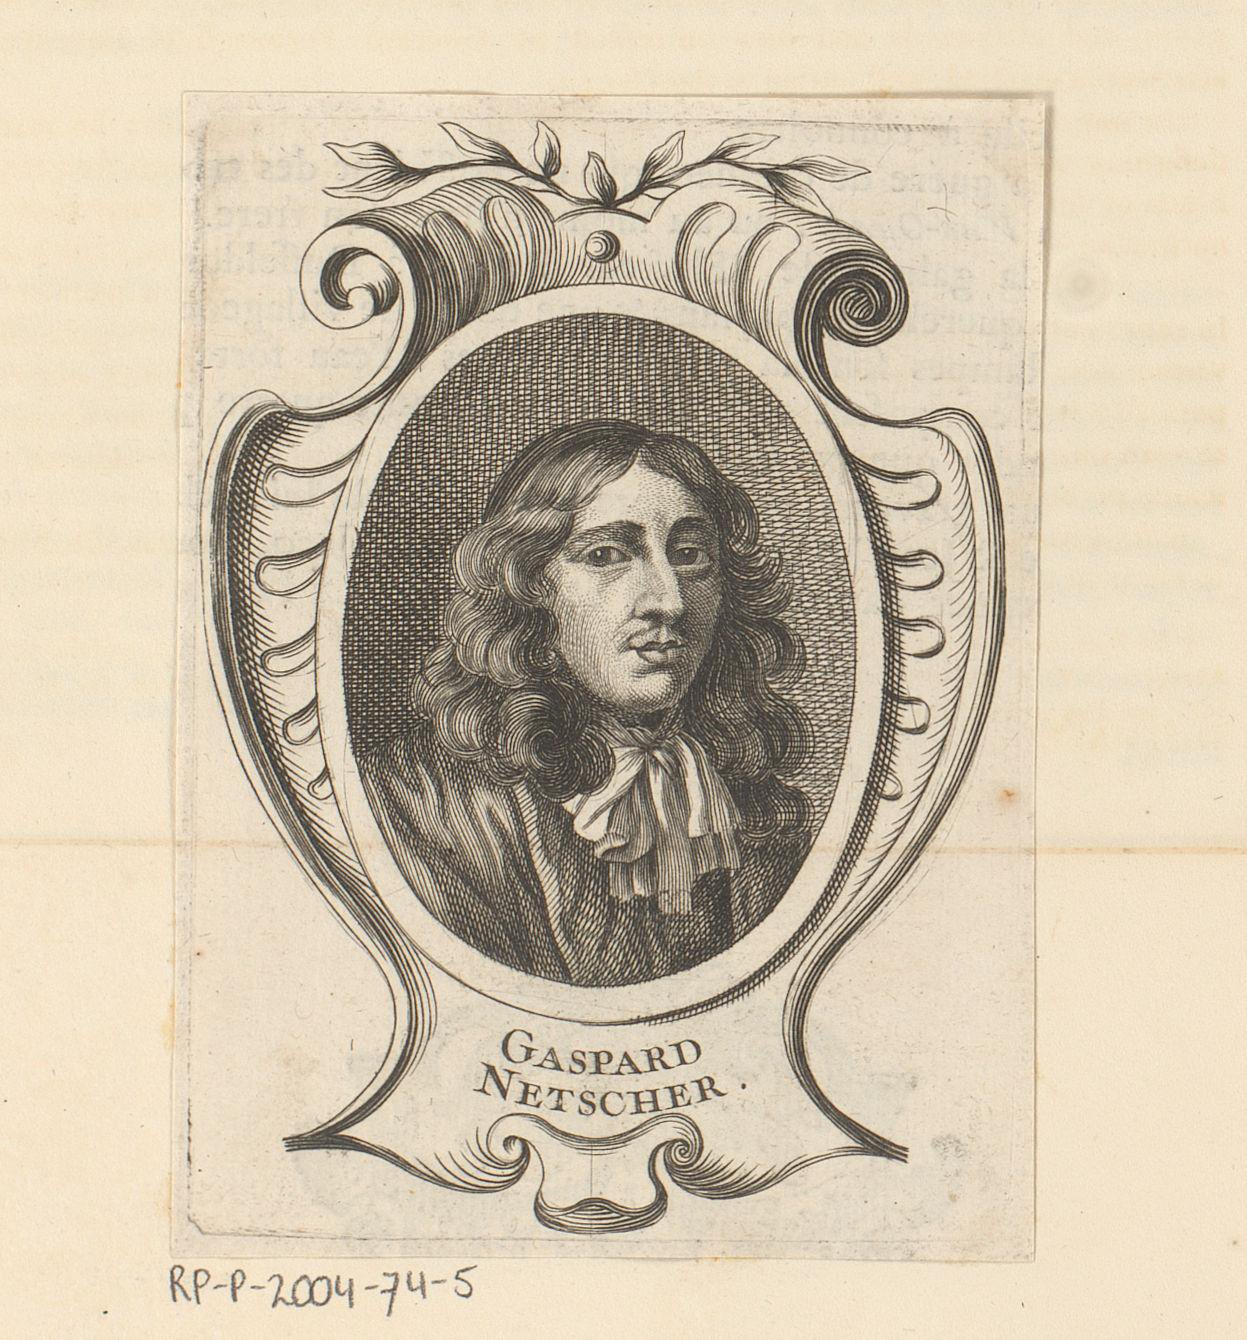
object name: print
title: Portret van Caspar Netscher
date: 1745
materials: paper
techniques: engraving, letterpress printing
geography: paris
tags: the hague, painter, print maker, draughtsman, caspar netscher, historical persons, portrait, self-portrait of painter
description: Prent uit: Dézallier d'Argenville, Antoine Joseph. Abrégé de la vie des plus fameux peintres. 4 dln. Parijs: De Bure l'aîné, 1745, dl. 2, p. 38. De samensteller heeft deze prent in het album geplakt als illustratie bij: Pilkington, Matthew en Johann Heinrich Füssli. A dictionary of painters, from the revival of the art to the present period. 4 dln. Londen: John Crowder, 1805, dl. 3, p. 363.